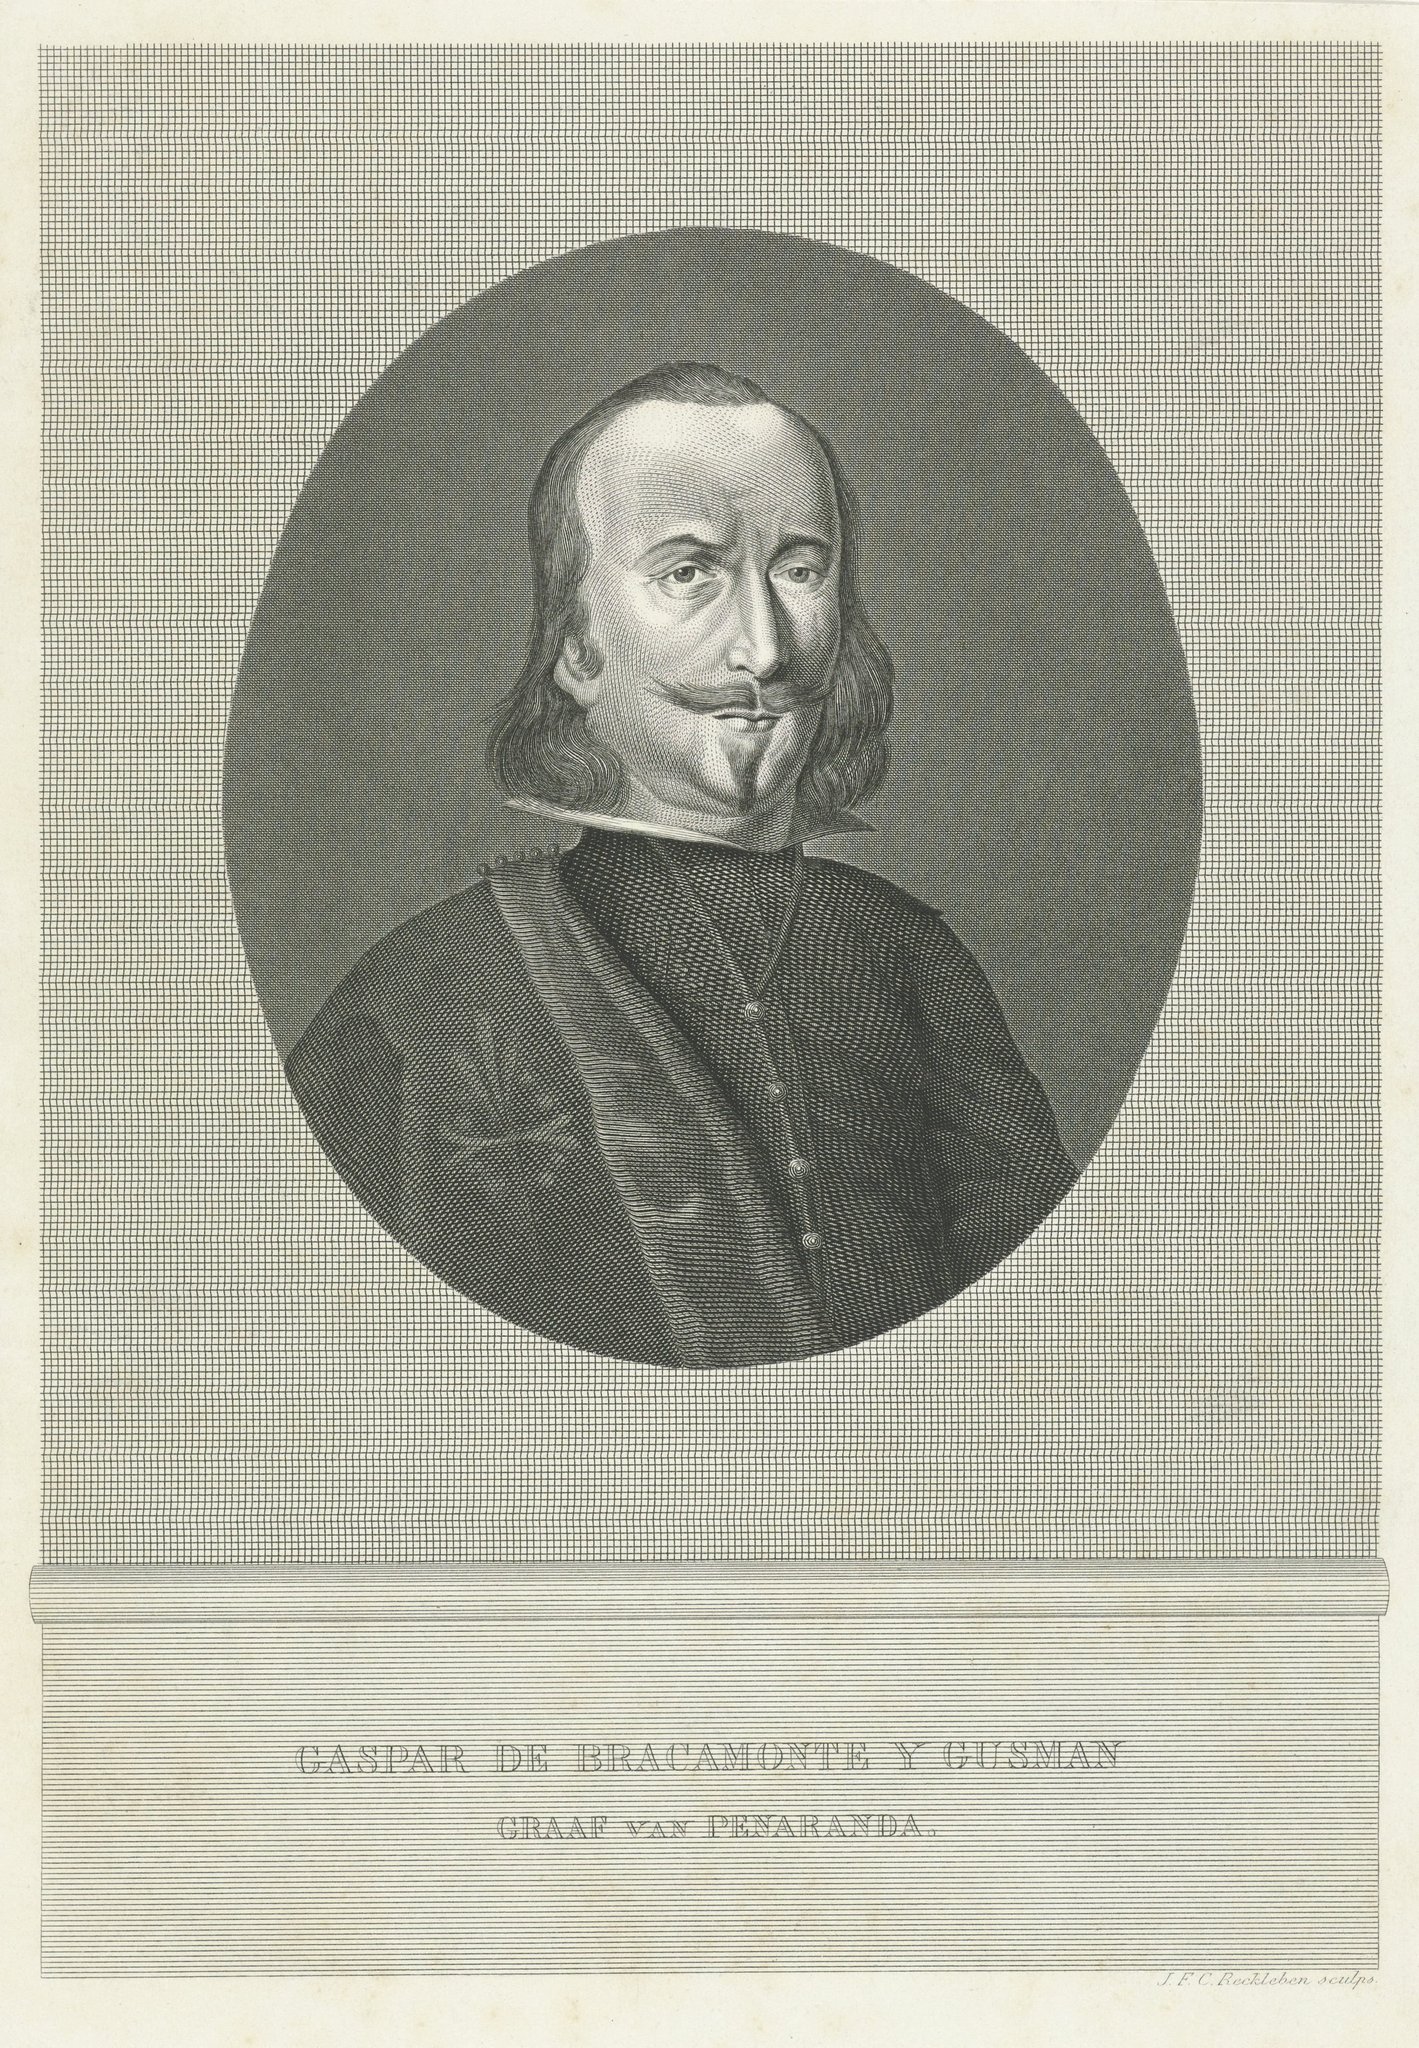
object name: print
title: Portret van Gaspar de Bracamonte y Guzman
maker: jan frederik christiaan reckleben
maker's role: print maker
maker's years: 1819-1879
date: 1866-1868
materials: paper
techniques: engraving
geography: amsterdam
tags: gaspar de bracamonte y guzman (graaf van peñaranda), historical persons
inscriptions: collector's mark: Lugt 2228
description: Illustratie in: Arend, Johannes Pieter. Algemeene geschiedenis des vaderlands van de vroegste tijden tot op heden. 5 delen, Amsterdam: Schleijer, J.F. 1840-1884, dl. 3.5, p. 612.